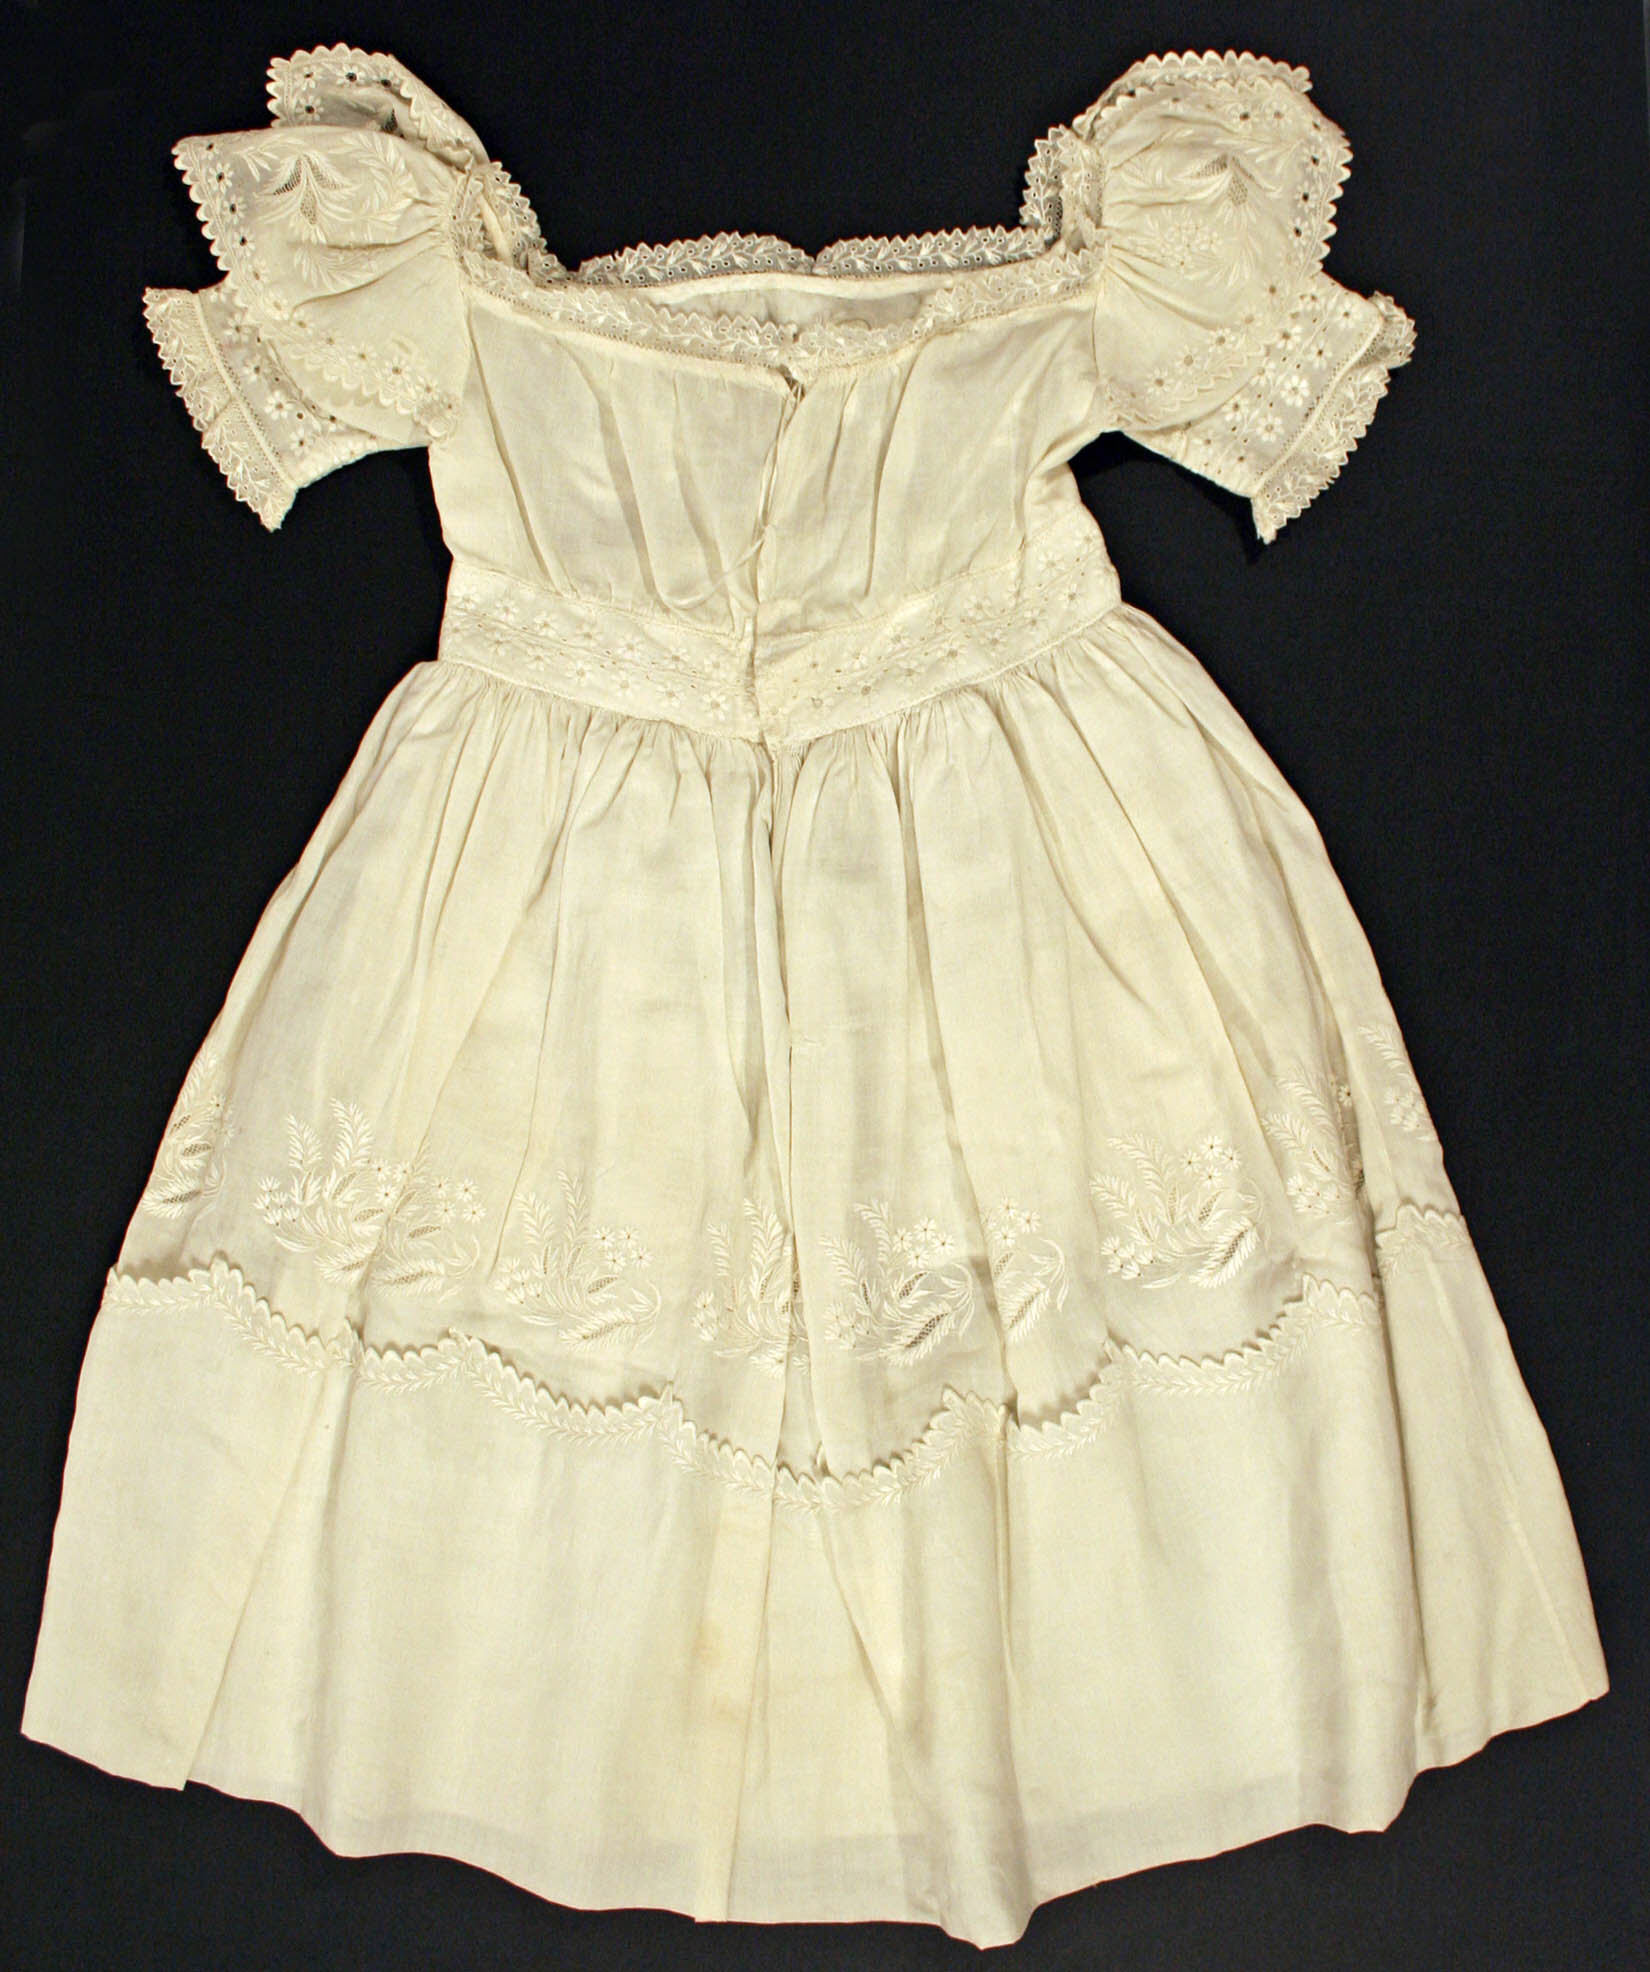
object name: dress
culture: american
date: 1830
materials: cotton